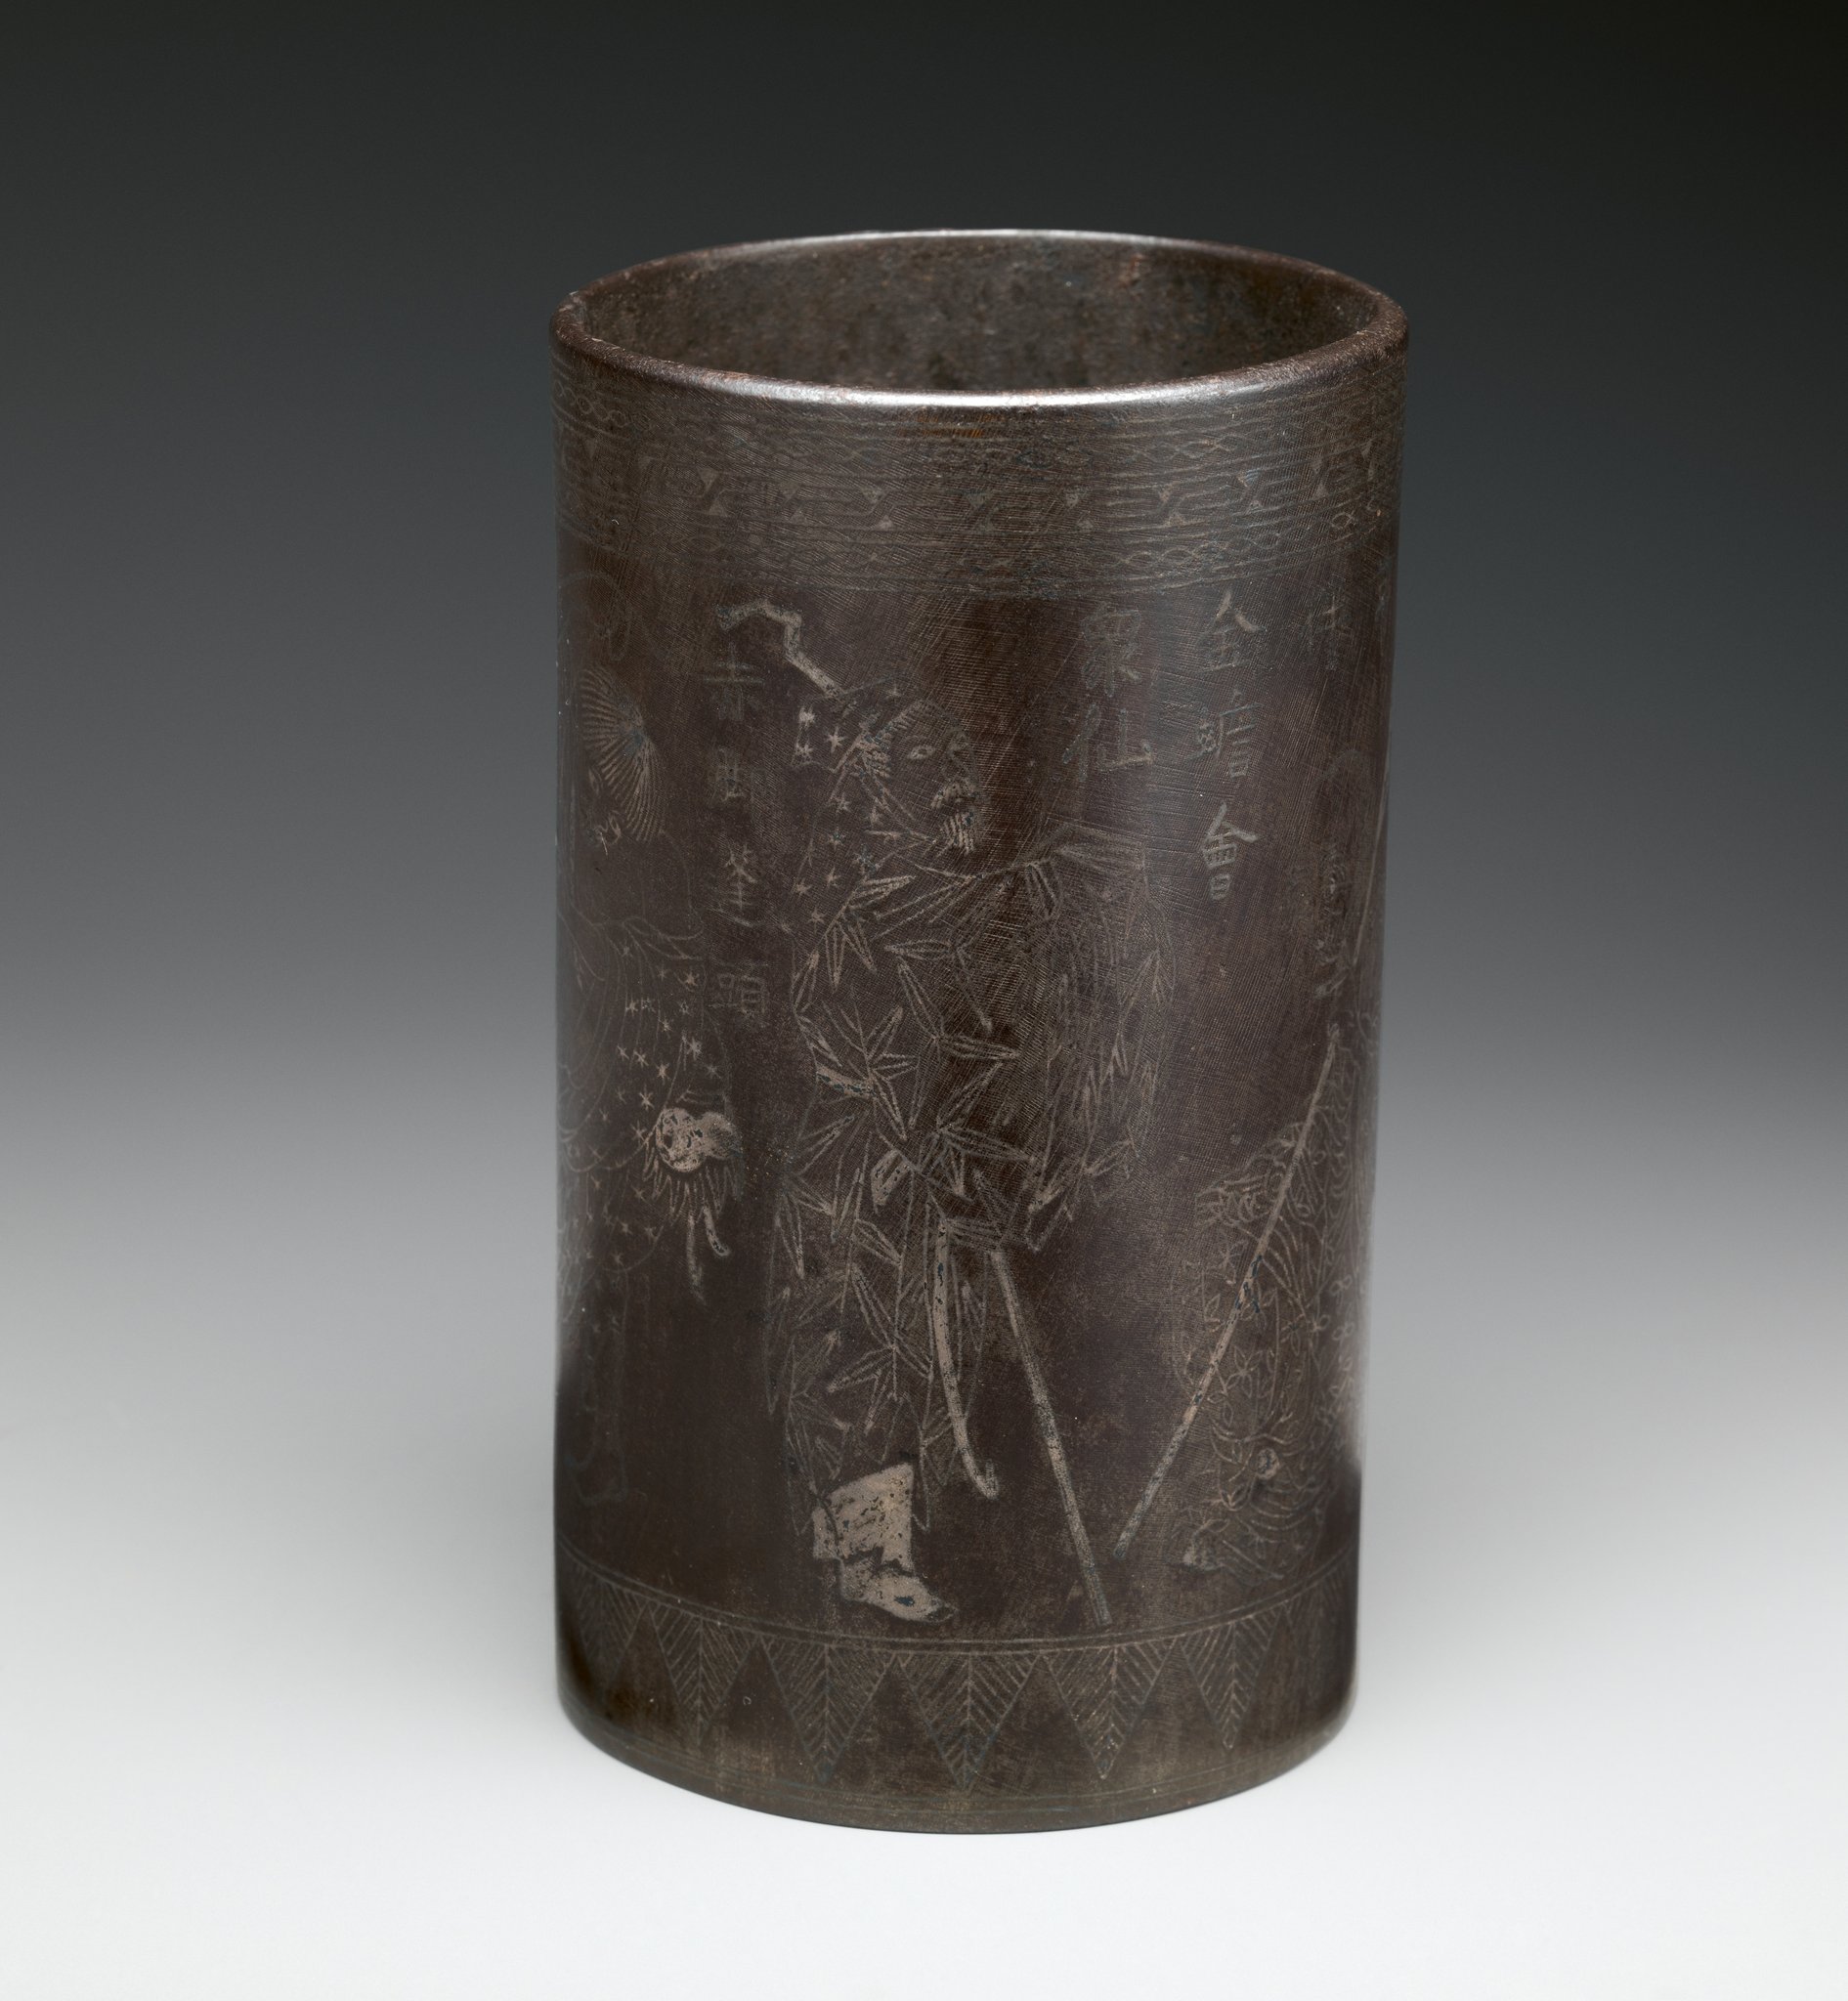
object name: brush pot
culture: chinese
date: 1701-1800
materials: iron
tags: human figures